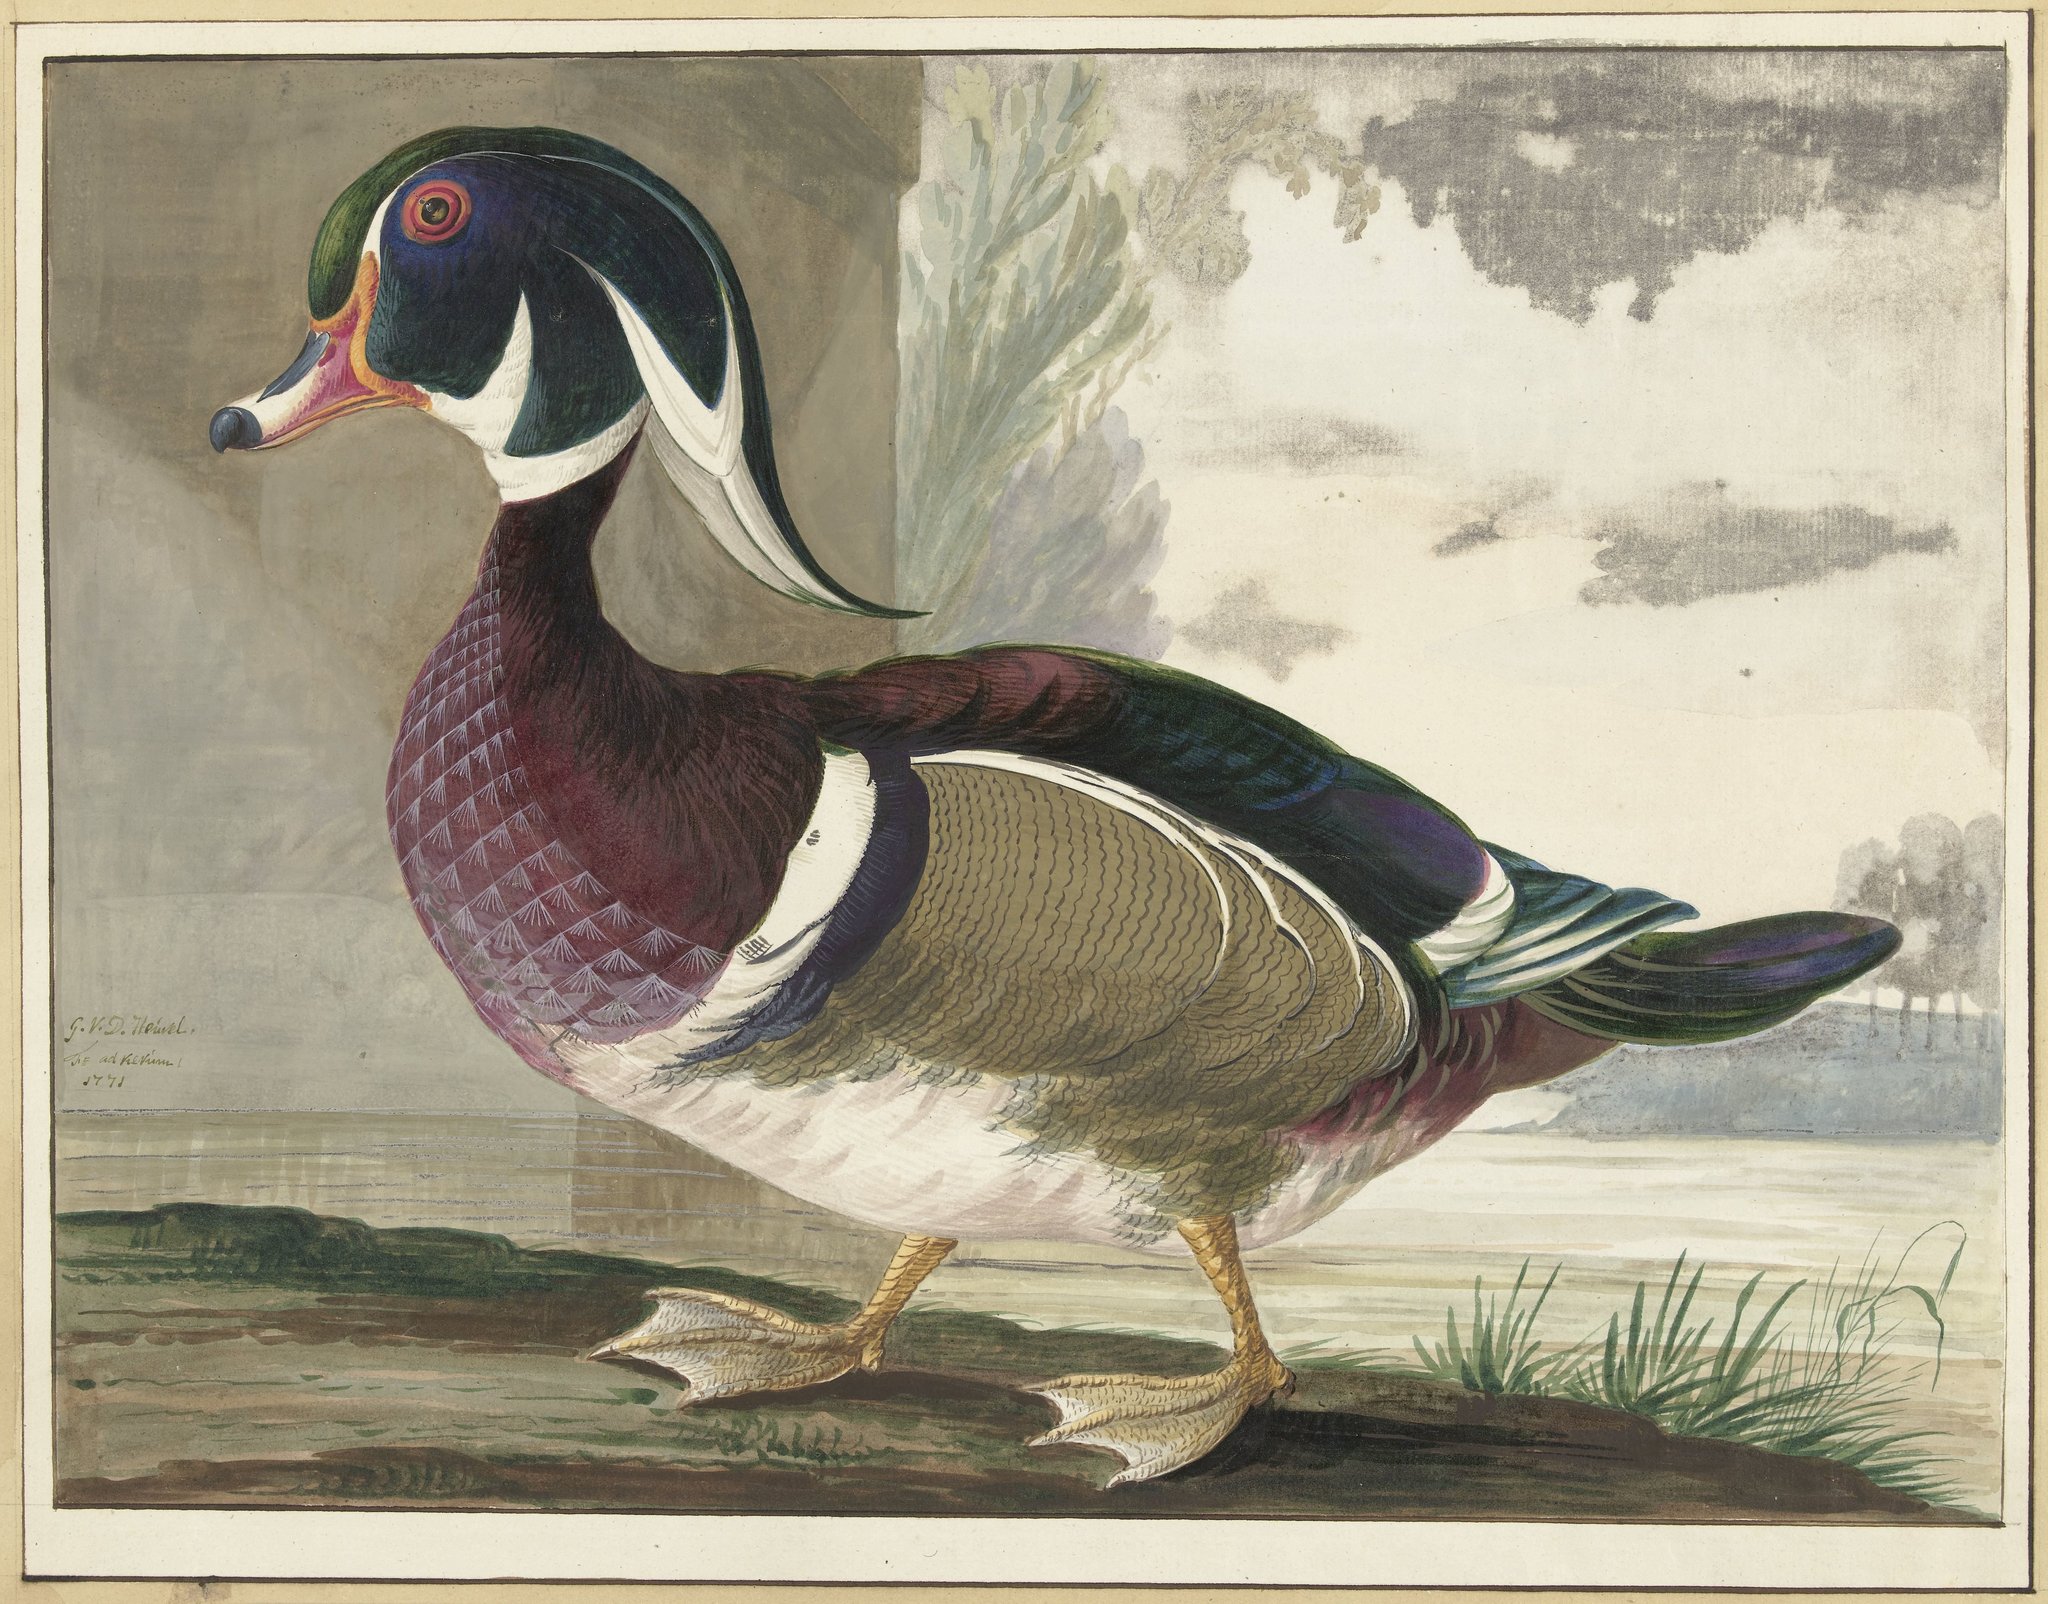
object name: watercolor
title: Carolina eend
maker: gerrit van den heuvel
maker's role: draughtsman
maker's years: 1725-1809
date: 1771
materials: paper, pencil, watercolor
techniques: brush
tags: water-birds: duck